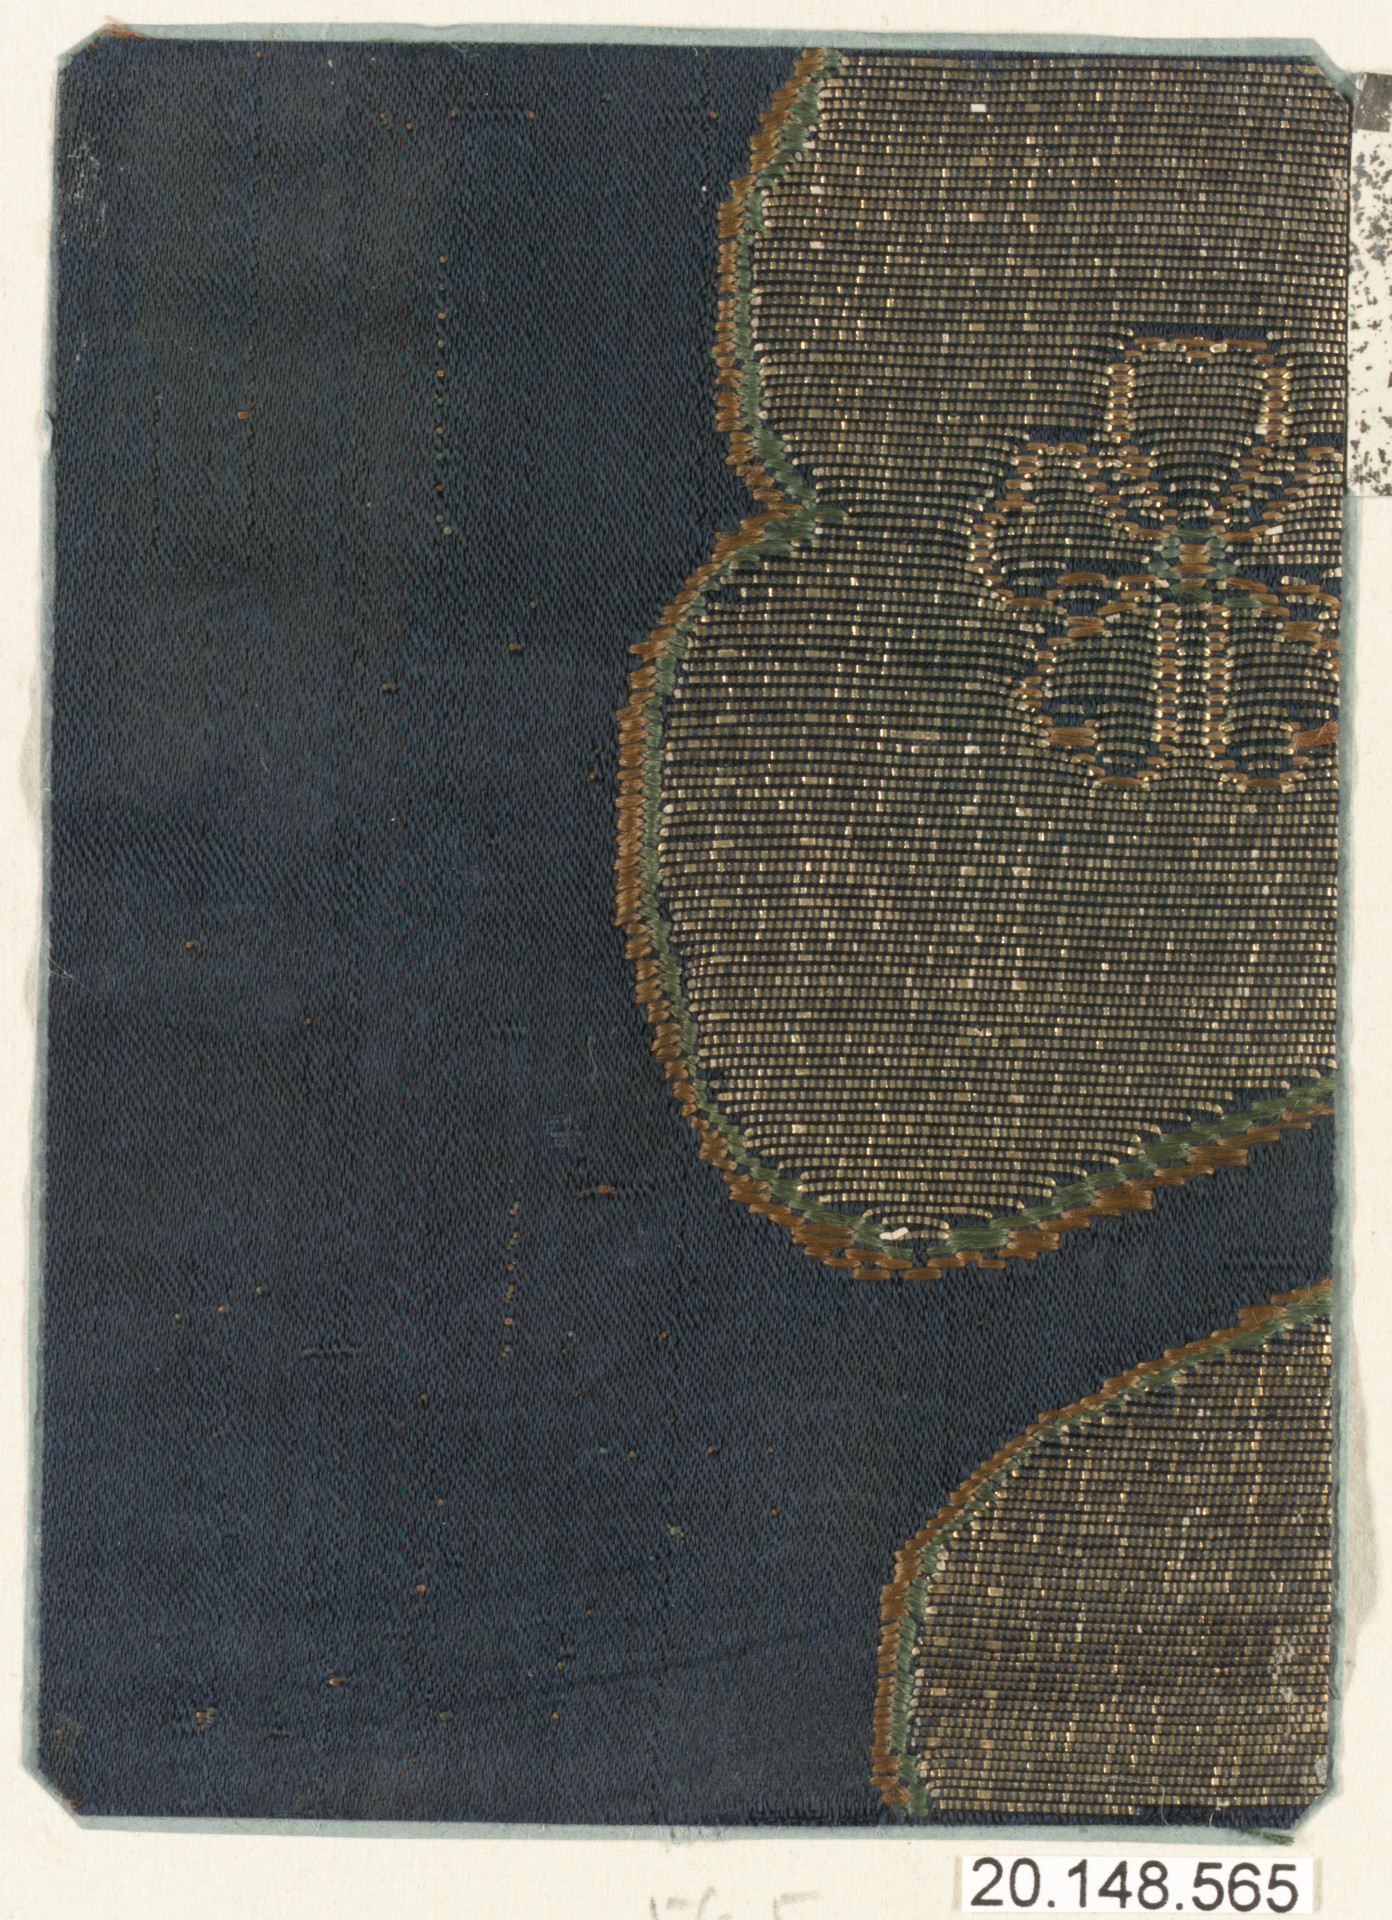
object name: piece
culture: japanese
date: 1701-1800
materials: silk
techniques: compound weave